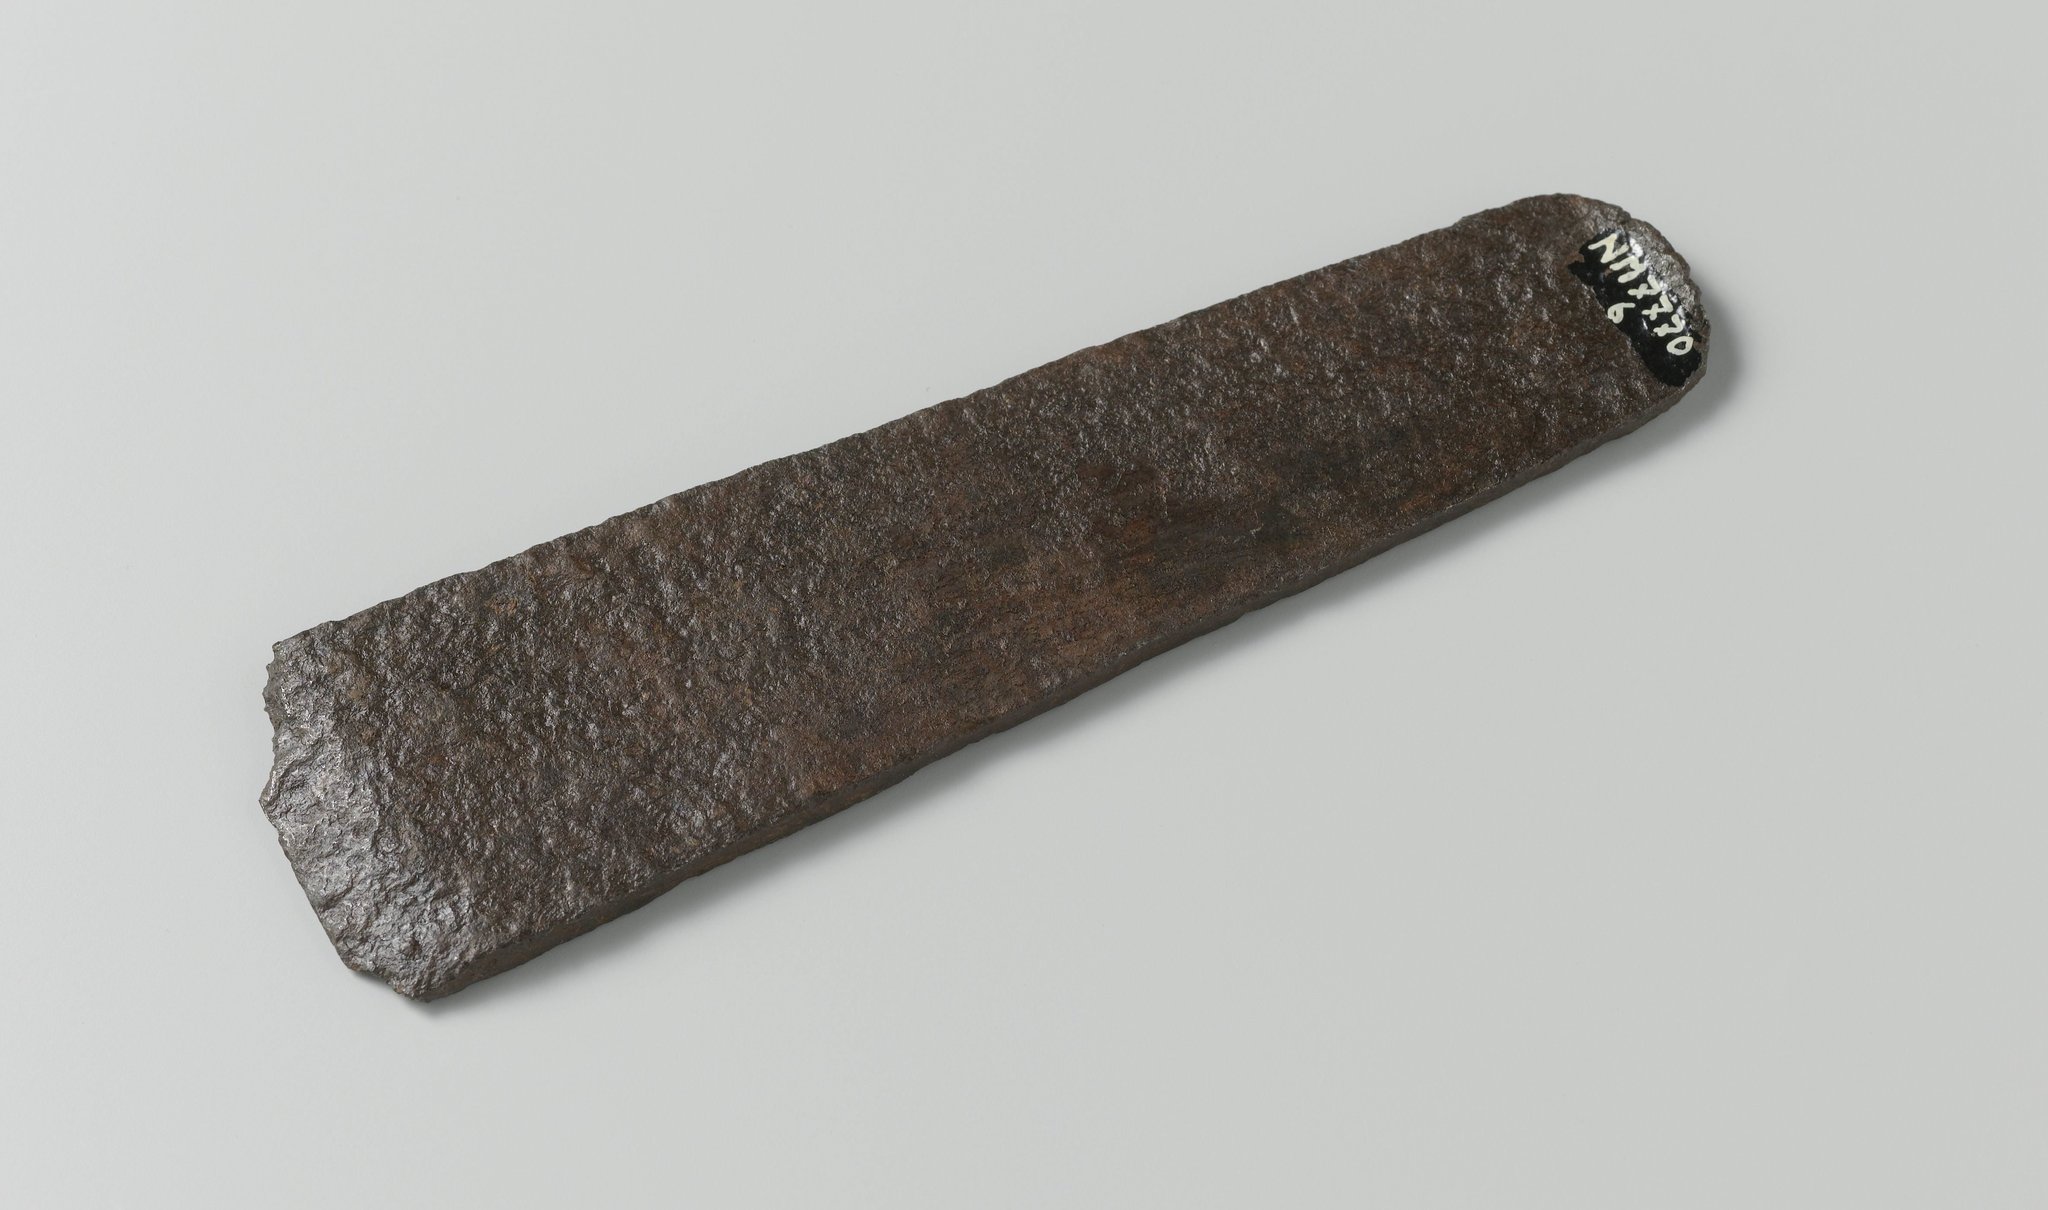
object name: chisel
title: Beitel, tapstoelopend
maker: Anonymous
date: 1590-1596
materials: iron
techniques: forging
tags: willem barendsz., amsterdam, jacob van heemskerck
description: Beitel, tapstoelopend waarvan de uiteinden die boven het blok uitsteken zijn lichtelijk in de richting van het blok omgebogen.